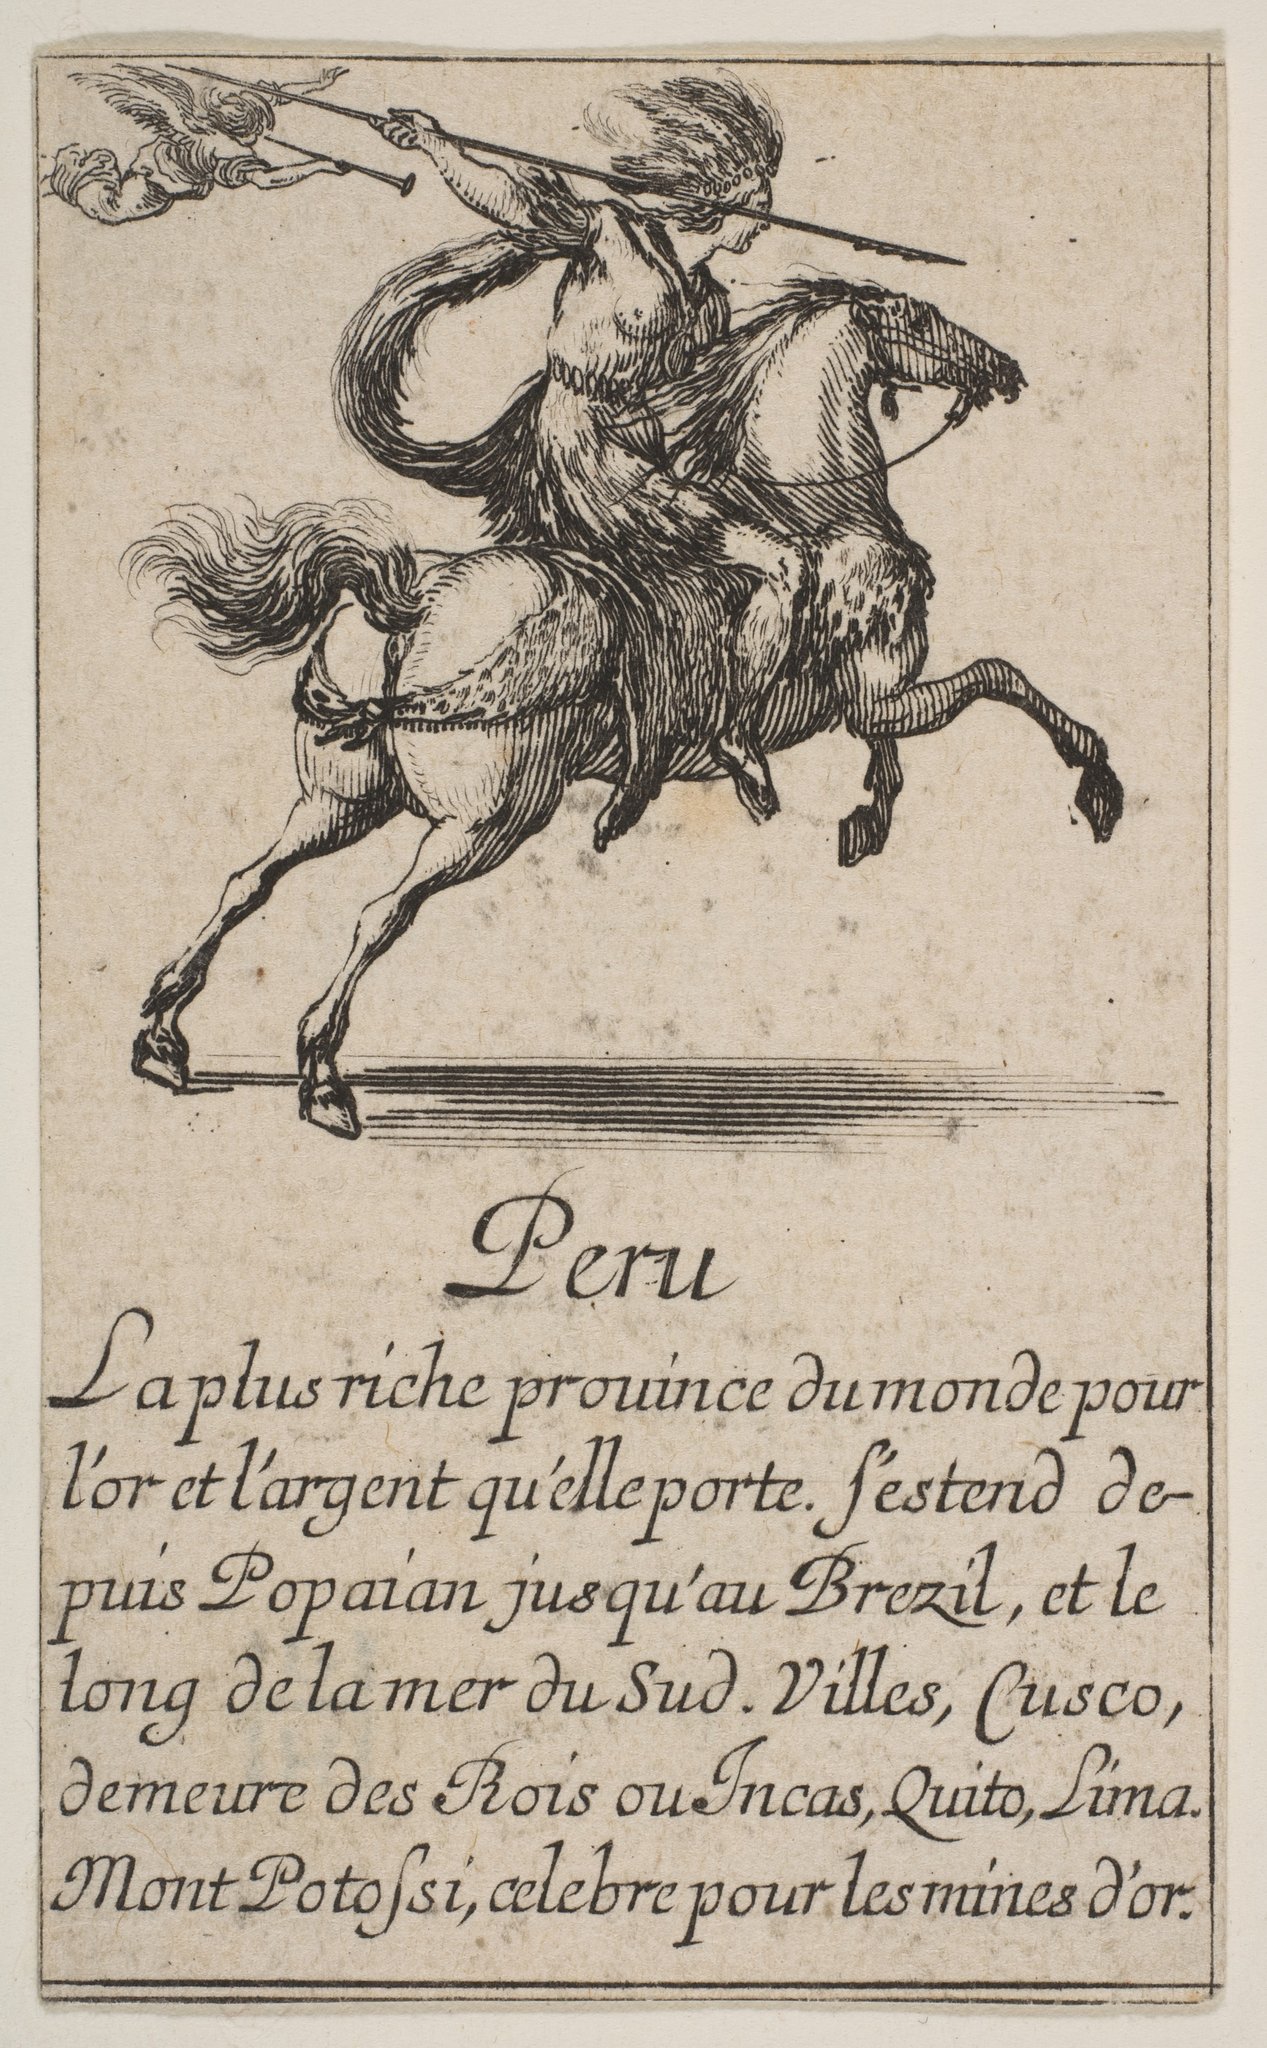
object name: print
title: Peru, from the playing cards "Jeu de la Géographie"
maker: stefano della bella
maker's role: artist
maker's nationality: italian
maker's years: 1610-1664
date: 1644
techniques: etching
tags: spears,men,horses